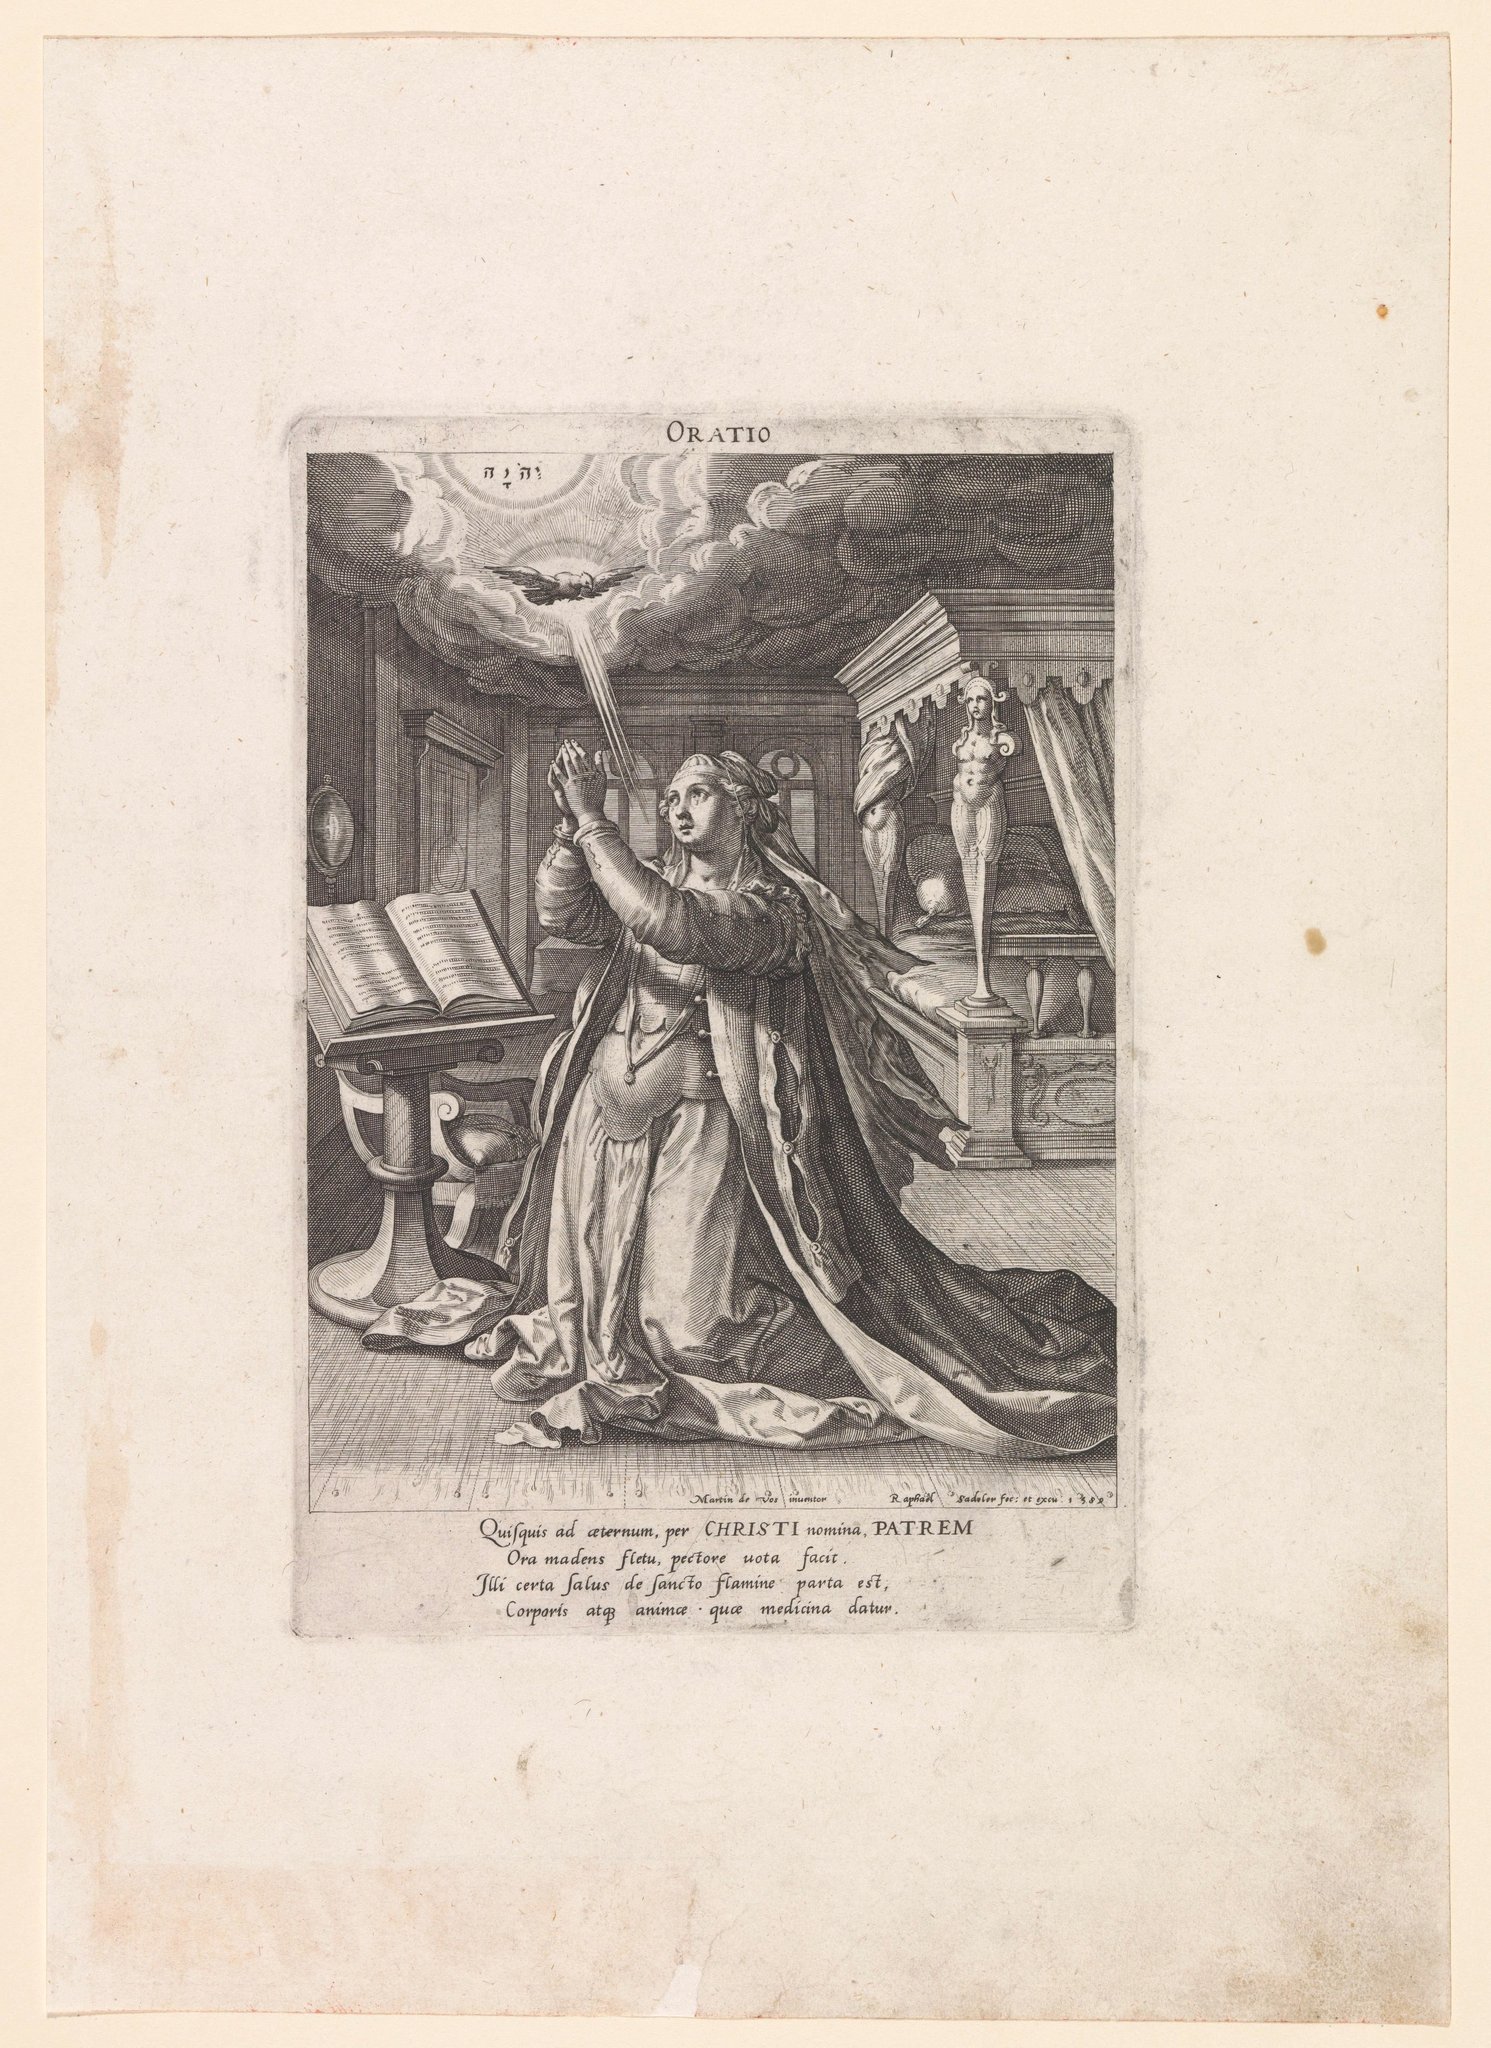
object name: print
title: Zes christelijke deugden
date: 1589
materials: paper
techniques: engraving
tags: tetragram (in roman or hebrew script) ~ symbol of god the father (+ holy ghost (as a dove)), (private) prayer; 'oratione', 'preghiere', 'preghiere a dio' (ripa)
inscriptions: collector's mark: Lugt 2228, collector's mark: Lugt 2760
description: Maria als de vrouwelijke personificatie van Gebed (Oratio). In een slaapvertrek knielt ze en vouwt ze haar handen in gebed. In de lucht het tetragram van God en de heilige Geest die als duif uit de hemel afdaalt. De vijfde prent uit een serie met als onderwerp zes christelijke deugden.